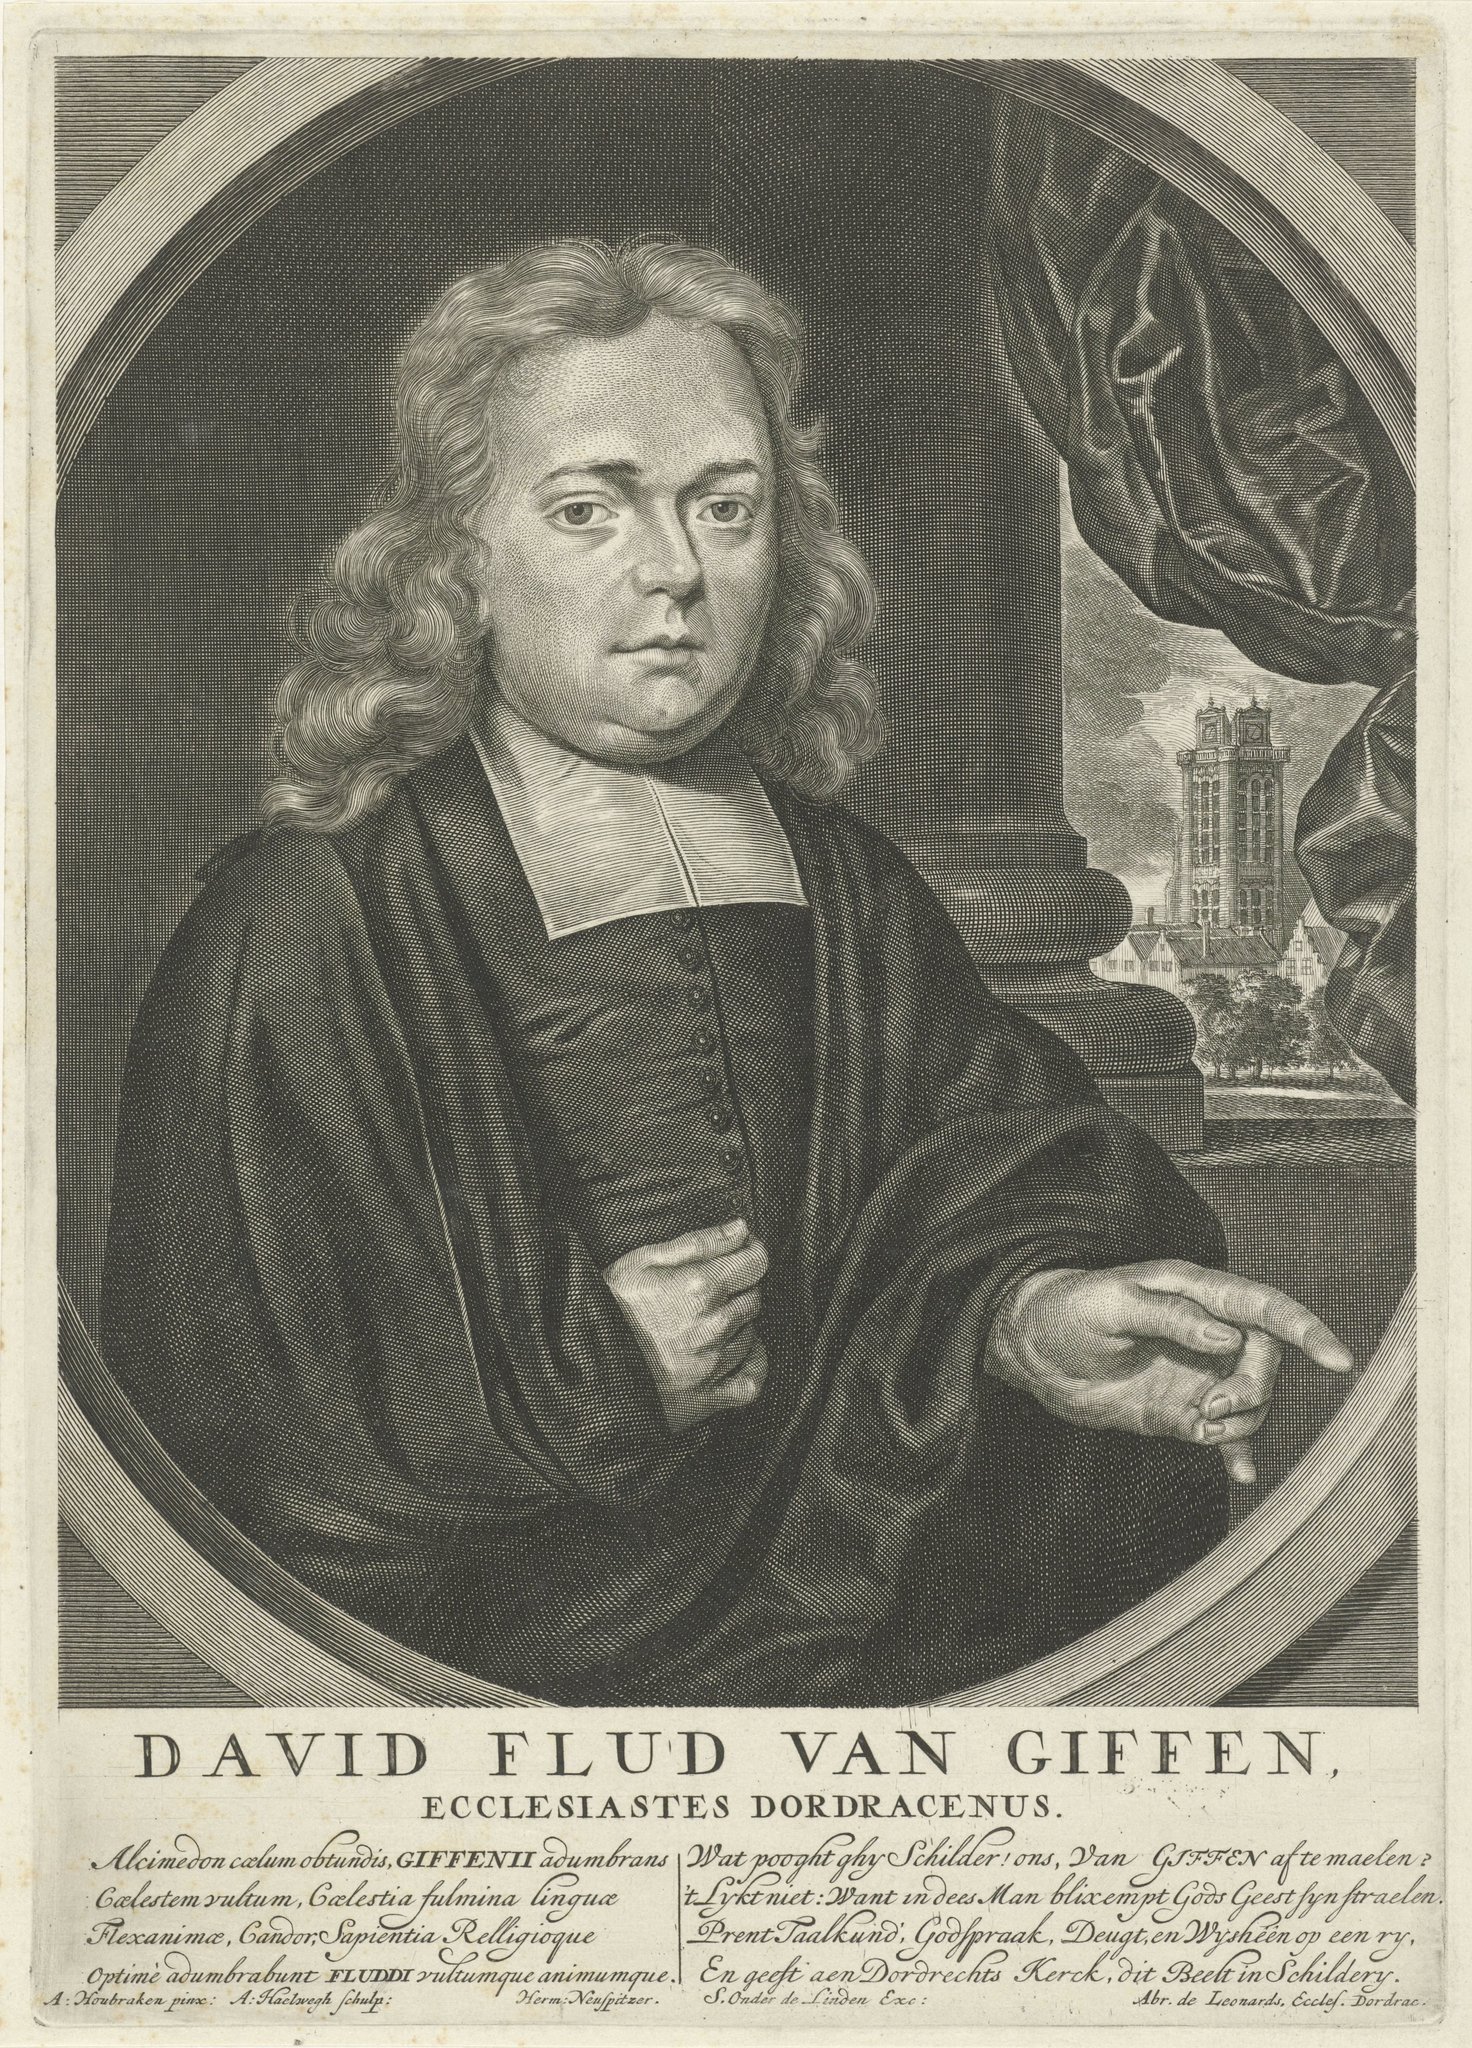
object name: print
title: Portret van David Flud van Giffen, predikant te Dordrecht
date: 1682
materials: paper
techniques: engraving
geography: dordrecht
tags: parts of church exterior and annexes: tower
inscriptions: collector's mark: Lugt 2228